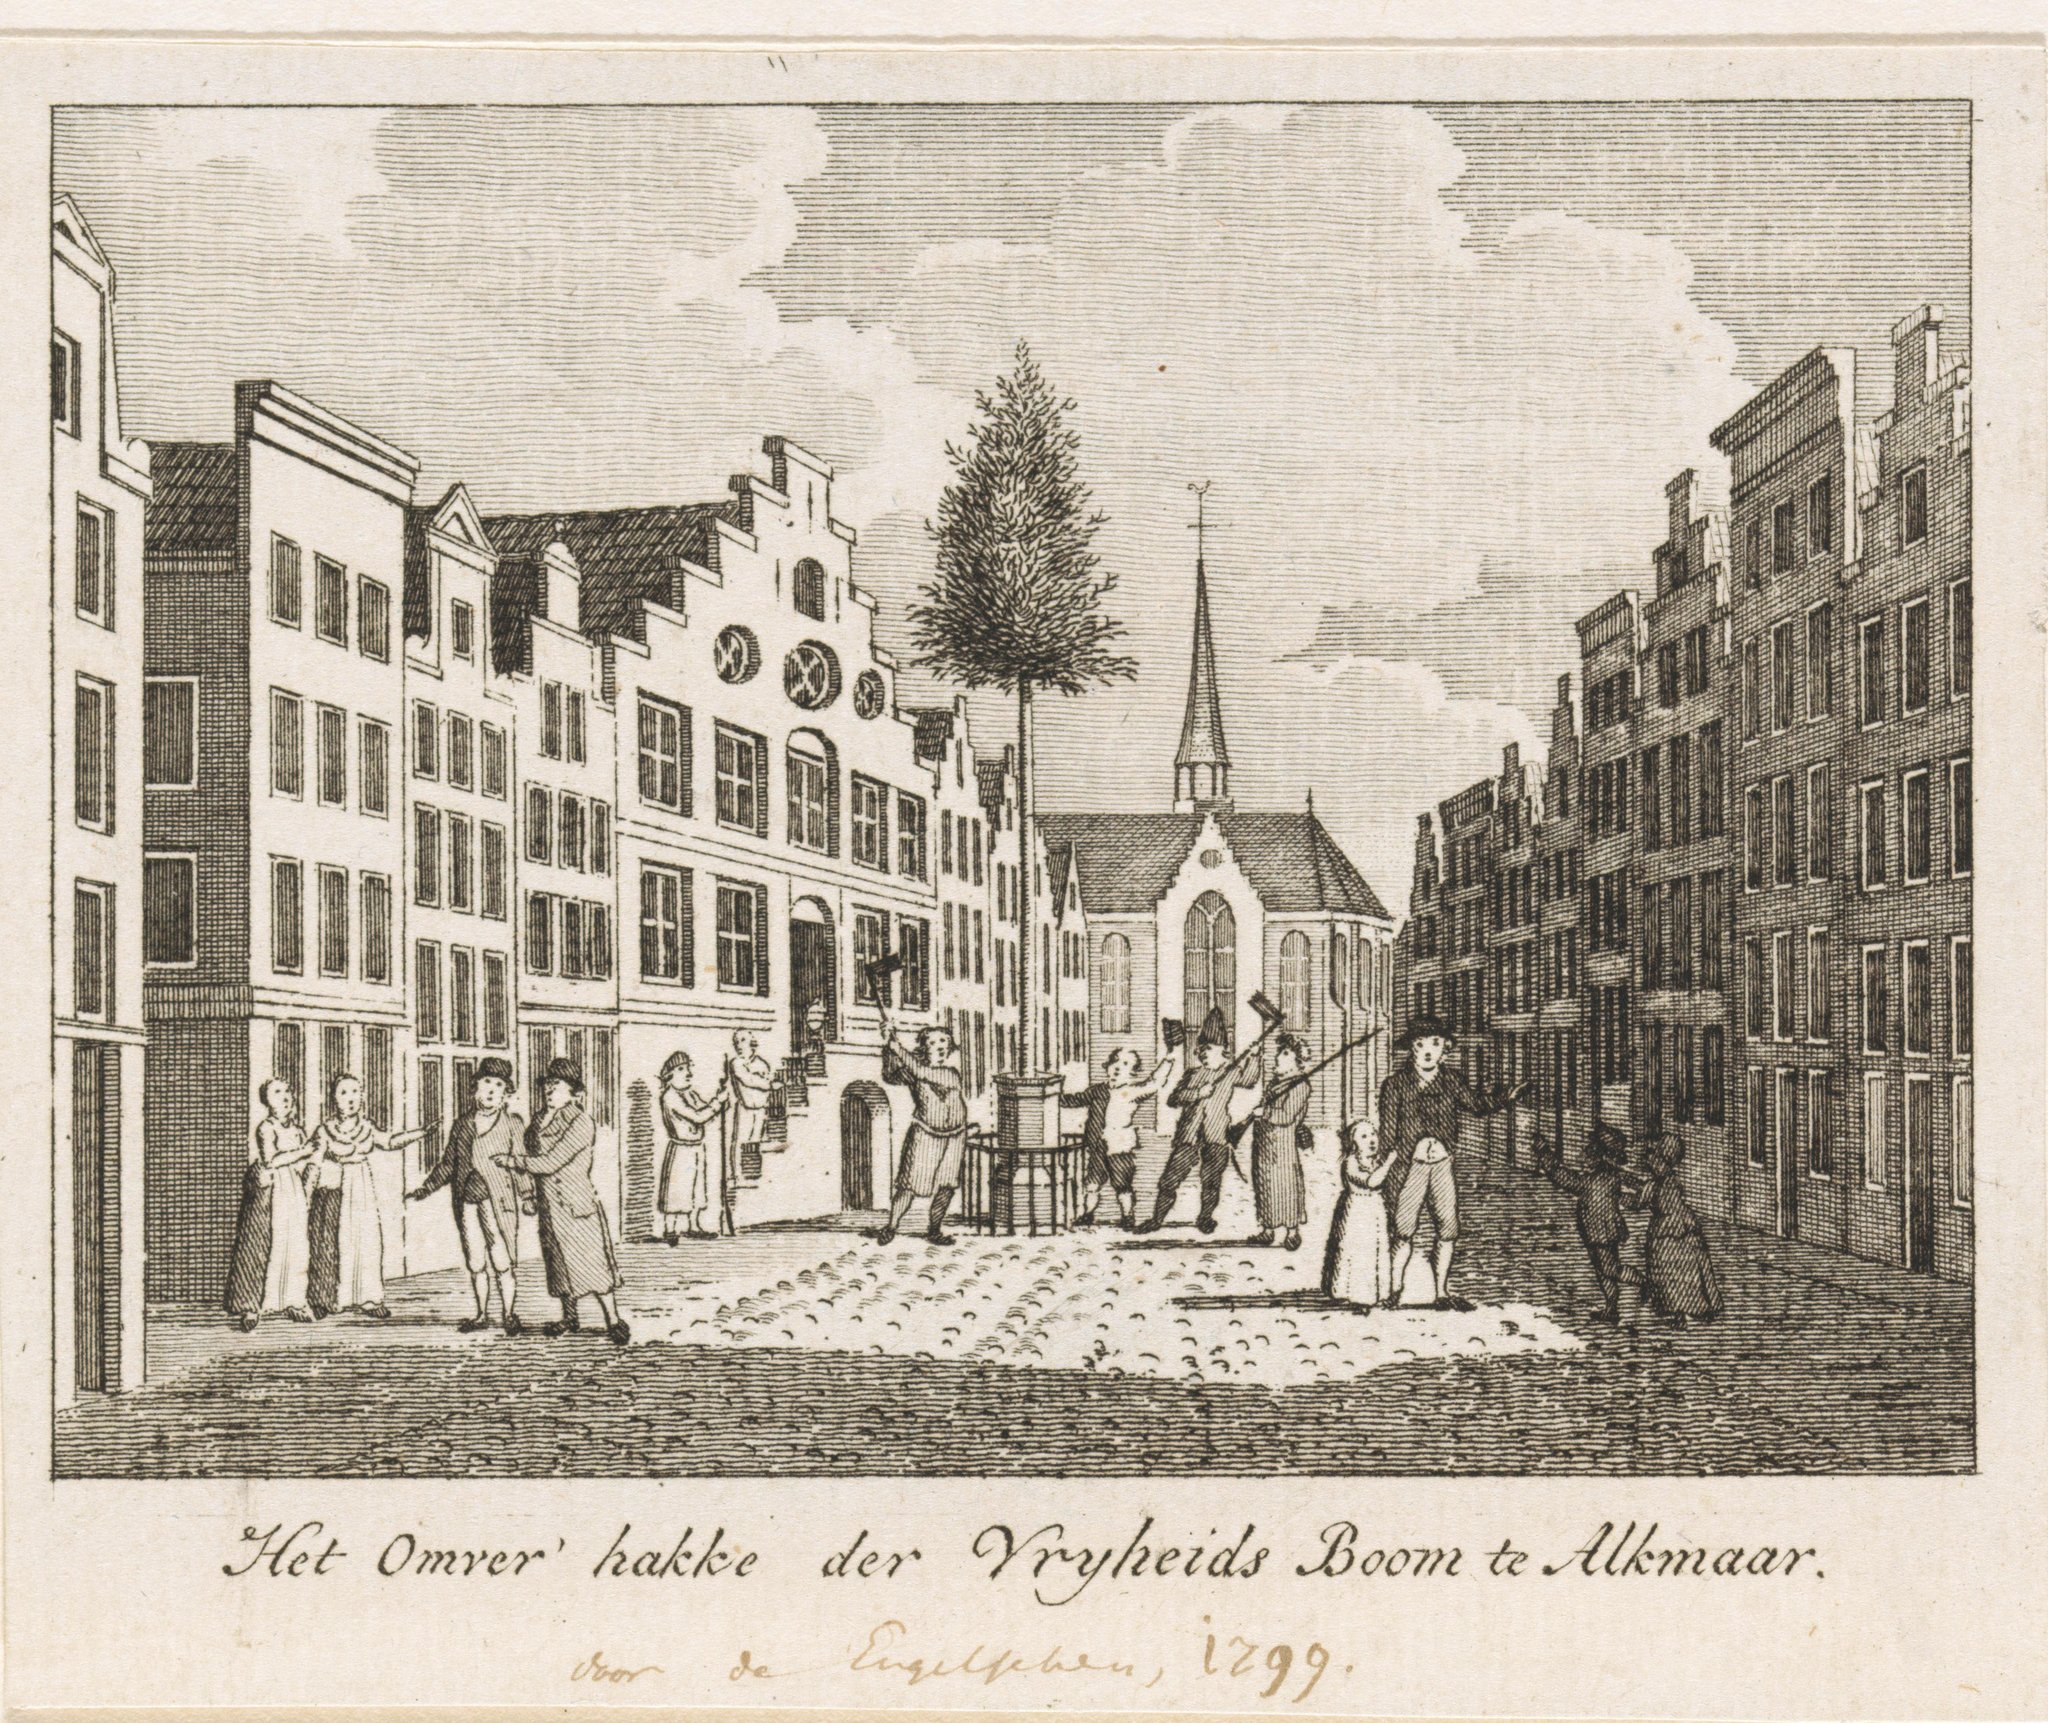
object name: print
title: Omhakken van de vrijheidsboom te Alkmaar, 1799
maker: Anonymous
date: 1800-1805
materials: paper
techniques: etching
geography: netherlands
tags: dancing around the tree of liberty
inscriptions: collector's mark: Lugt 2228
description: Het omver hakken (door de Engelsen) van de Vrijheidsboom in Alkmaar, 3 oktober 1799. Gezicht in een straat met in de verte de Grote Kerk.